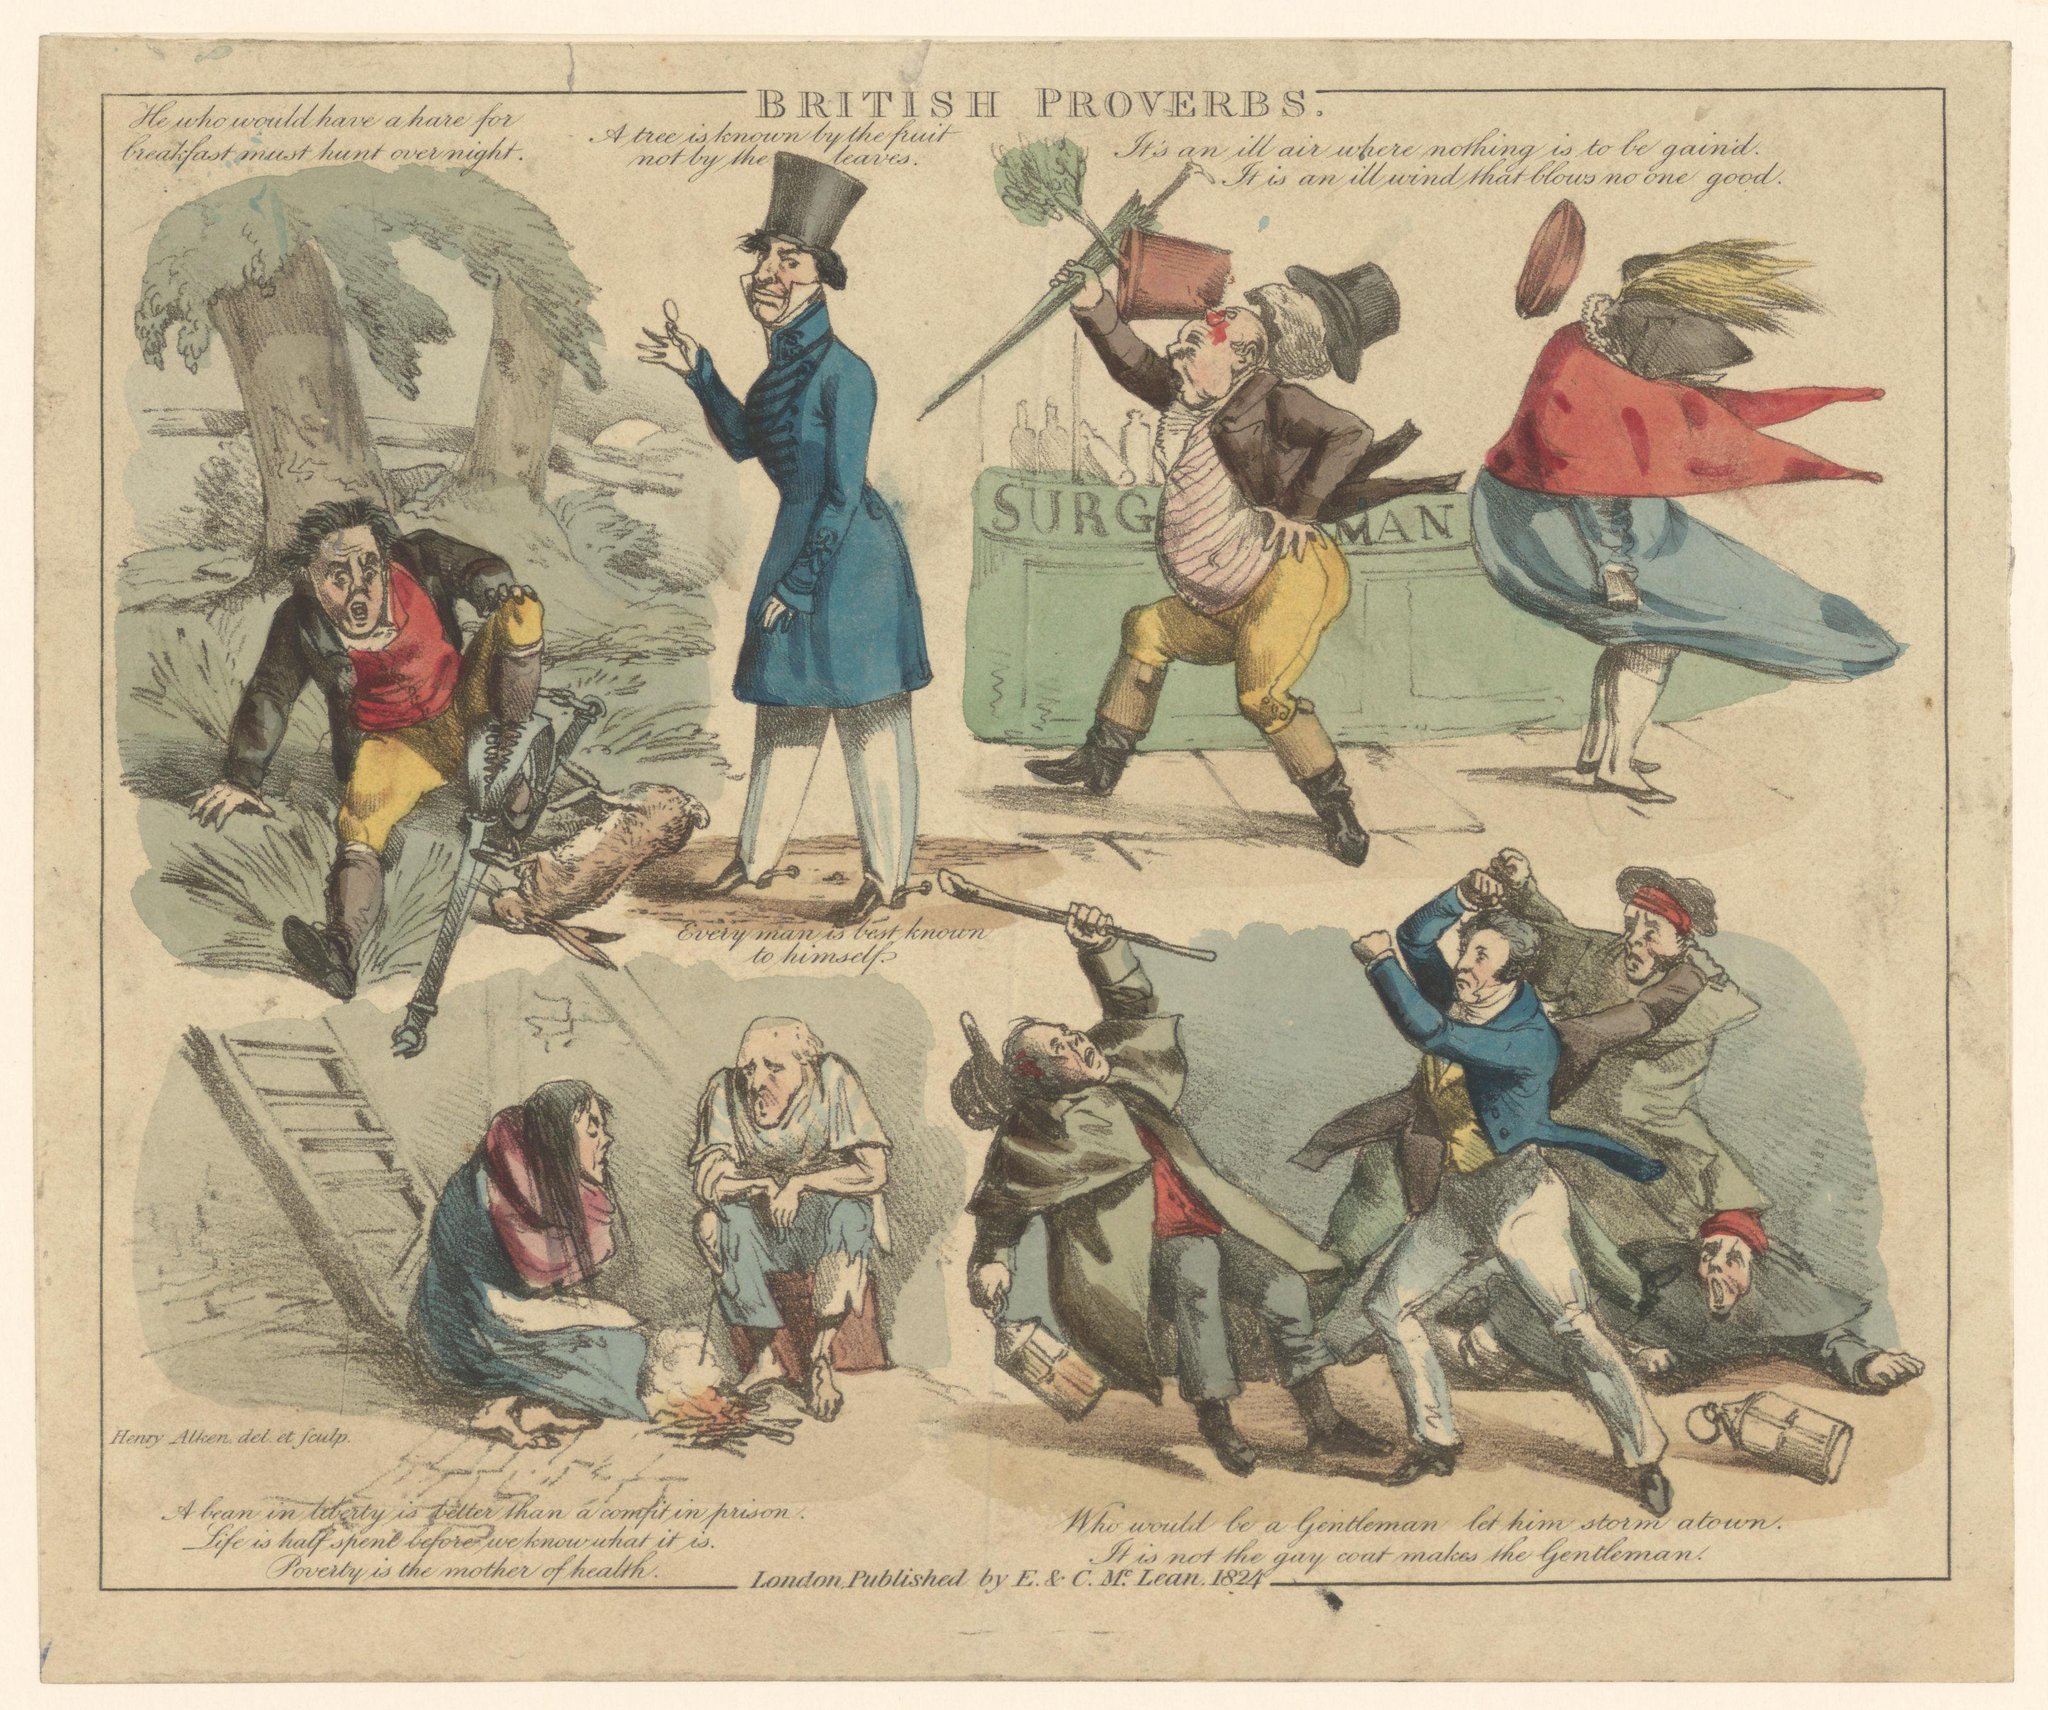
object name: print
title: British Proverbs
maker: henry alken (i)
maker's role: print maker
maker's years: 1774-1851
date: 1824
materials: paper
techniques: etching, hand coloring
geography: england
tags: hare-hunting, rabbit-hunting, the poor, fist-fight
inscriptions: collector's mark: Lugt 2233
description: Op de prent zijn vijf spreekwoorden geïllustreerd: He who would have a hare for breakfast must hunt overnight / A tree is known by the fruit not by the leaves. Every man is best known to himself / It's an ill air where nothing is to be gain'd. It is an ill wind that blows no one good / A bean in liberty is better than a comfit in prison. Life is half spent before we know what it is. Poverty is the mother of health / Who would be a Gentleman let him storm a town. It is not the gay coat makes the Gentleman.